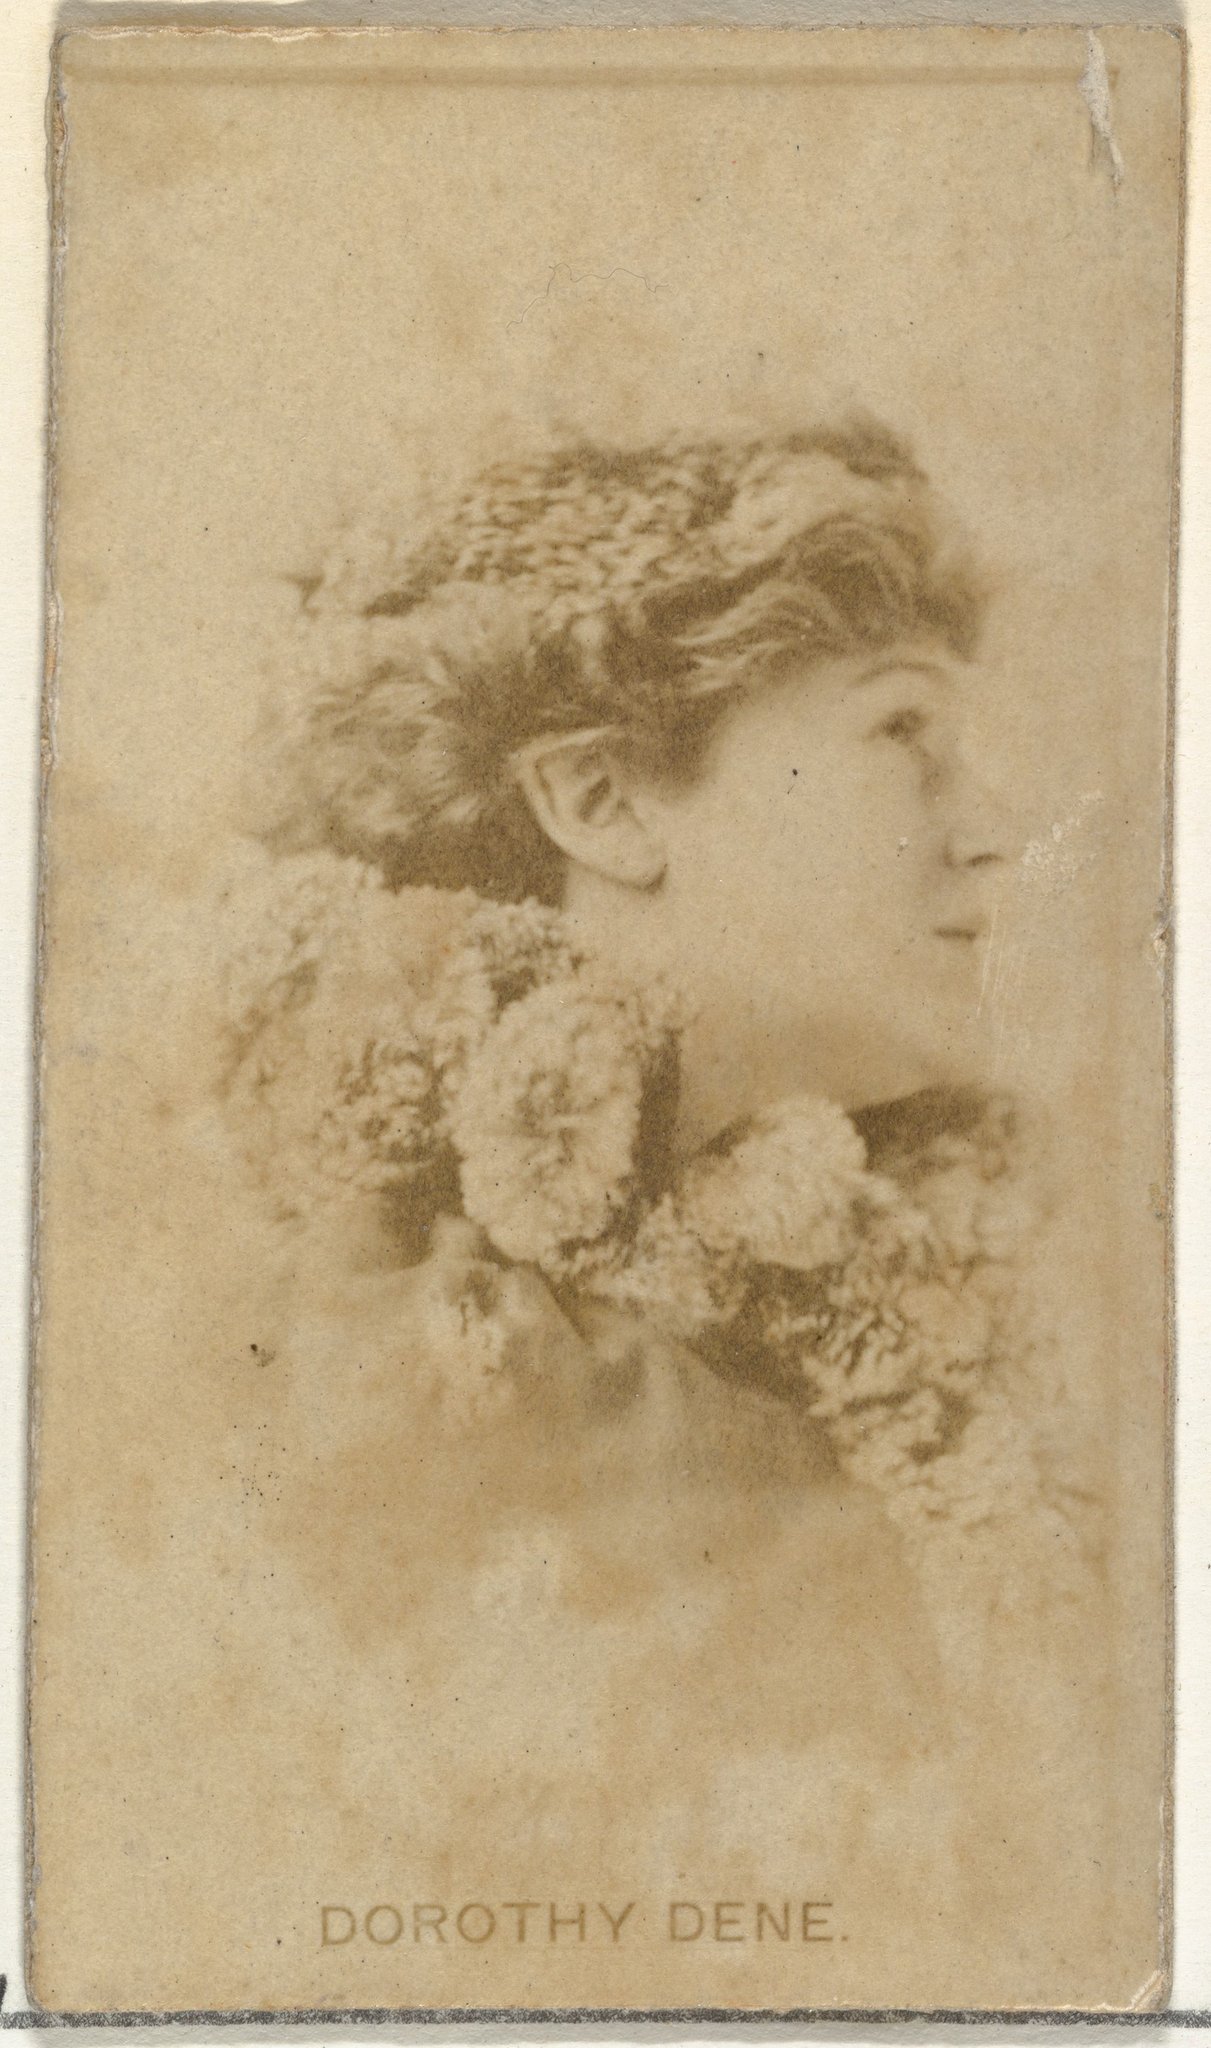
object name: photograph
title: Dorothy Dene, from the Actors and Actresses series (N145-8) issued by Duke Sons & Co. to promote Duke Cigarettes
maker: w. duke, sons & co.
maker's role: publisher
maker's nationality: american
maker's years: 1870-1920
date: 1891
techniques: albumen silver print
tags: portraits,women,actresses